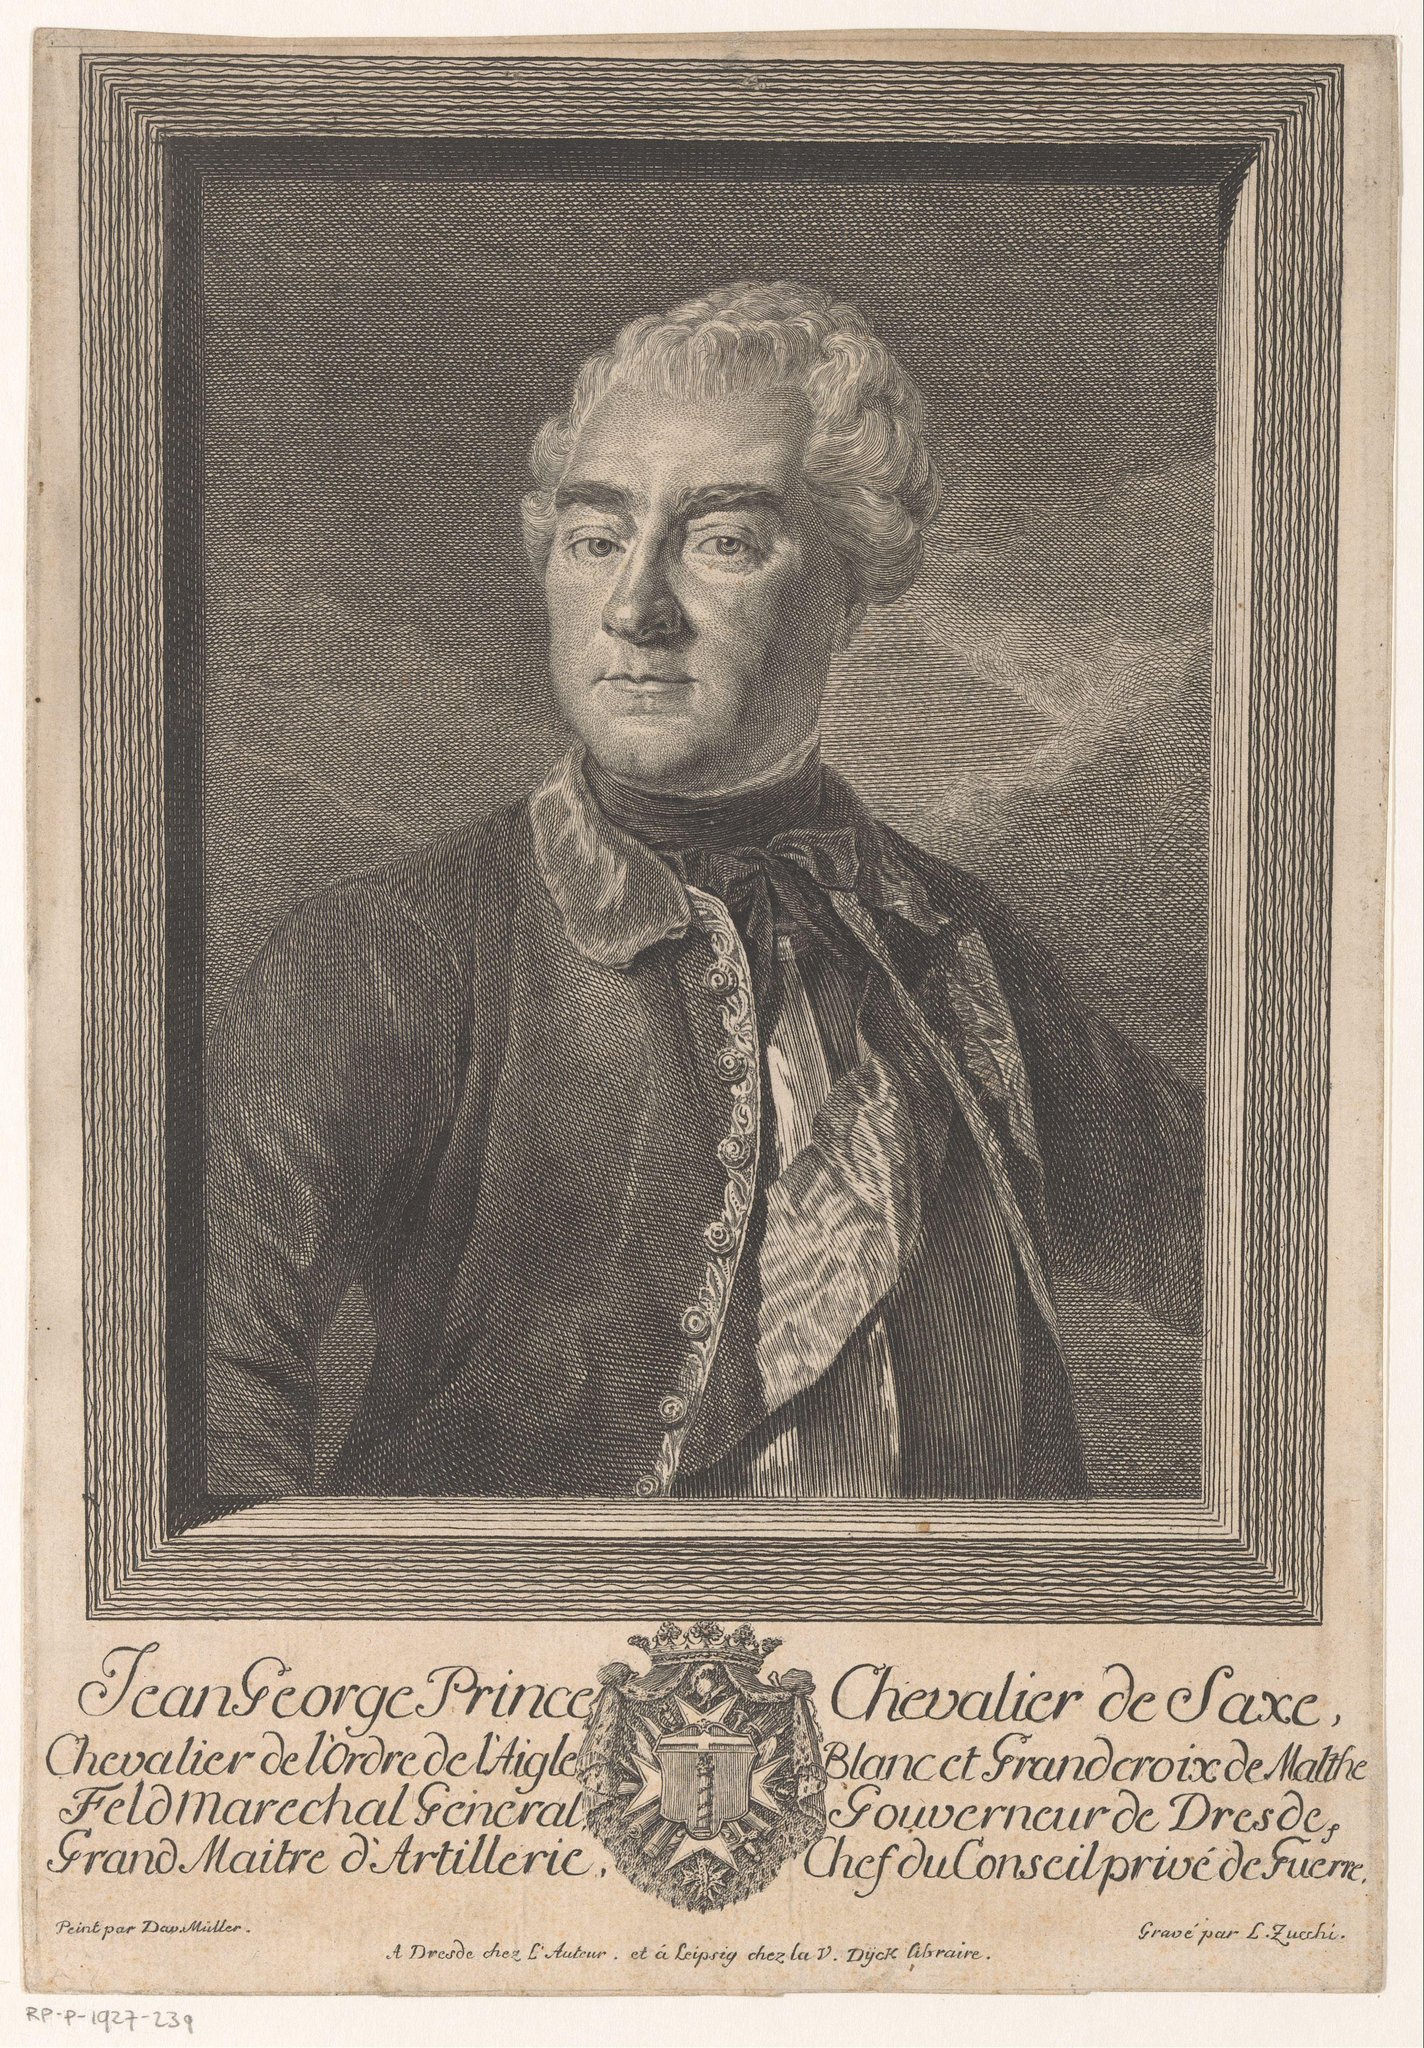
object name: print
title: Portret van generaal Johann Georg van Saksen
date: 1714-1779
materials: paper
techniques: engraving, etching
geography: dresden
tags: historical persons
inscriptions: collector's mark: Lugt 2166